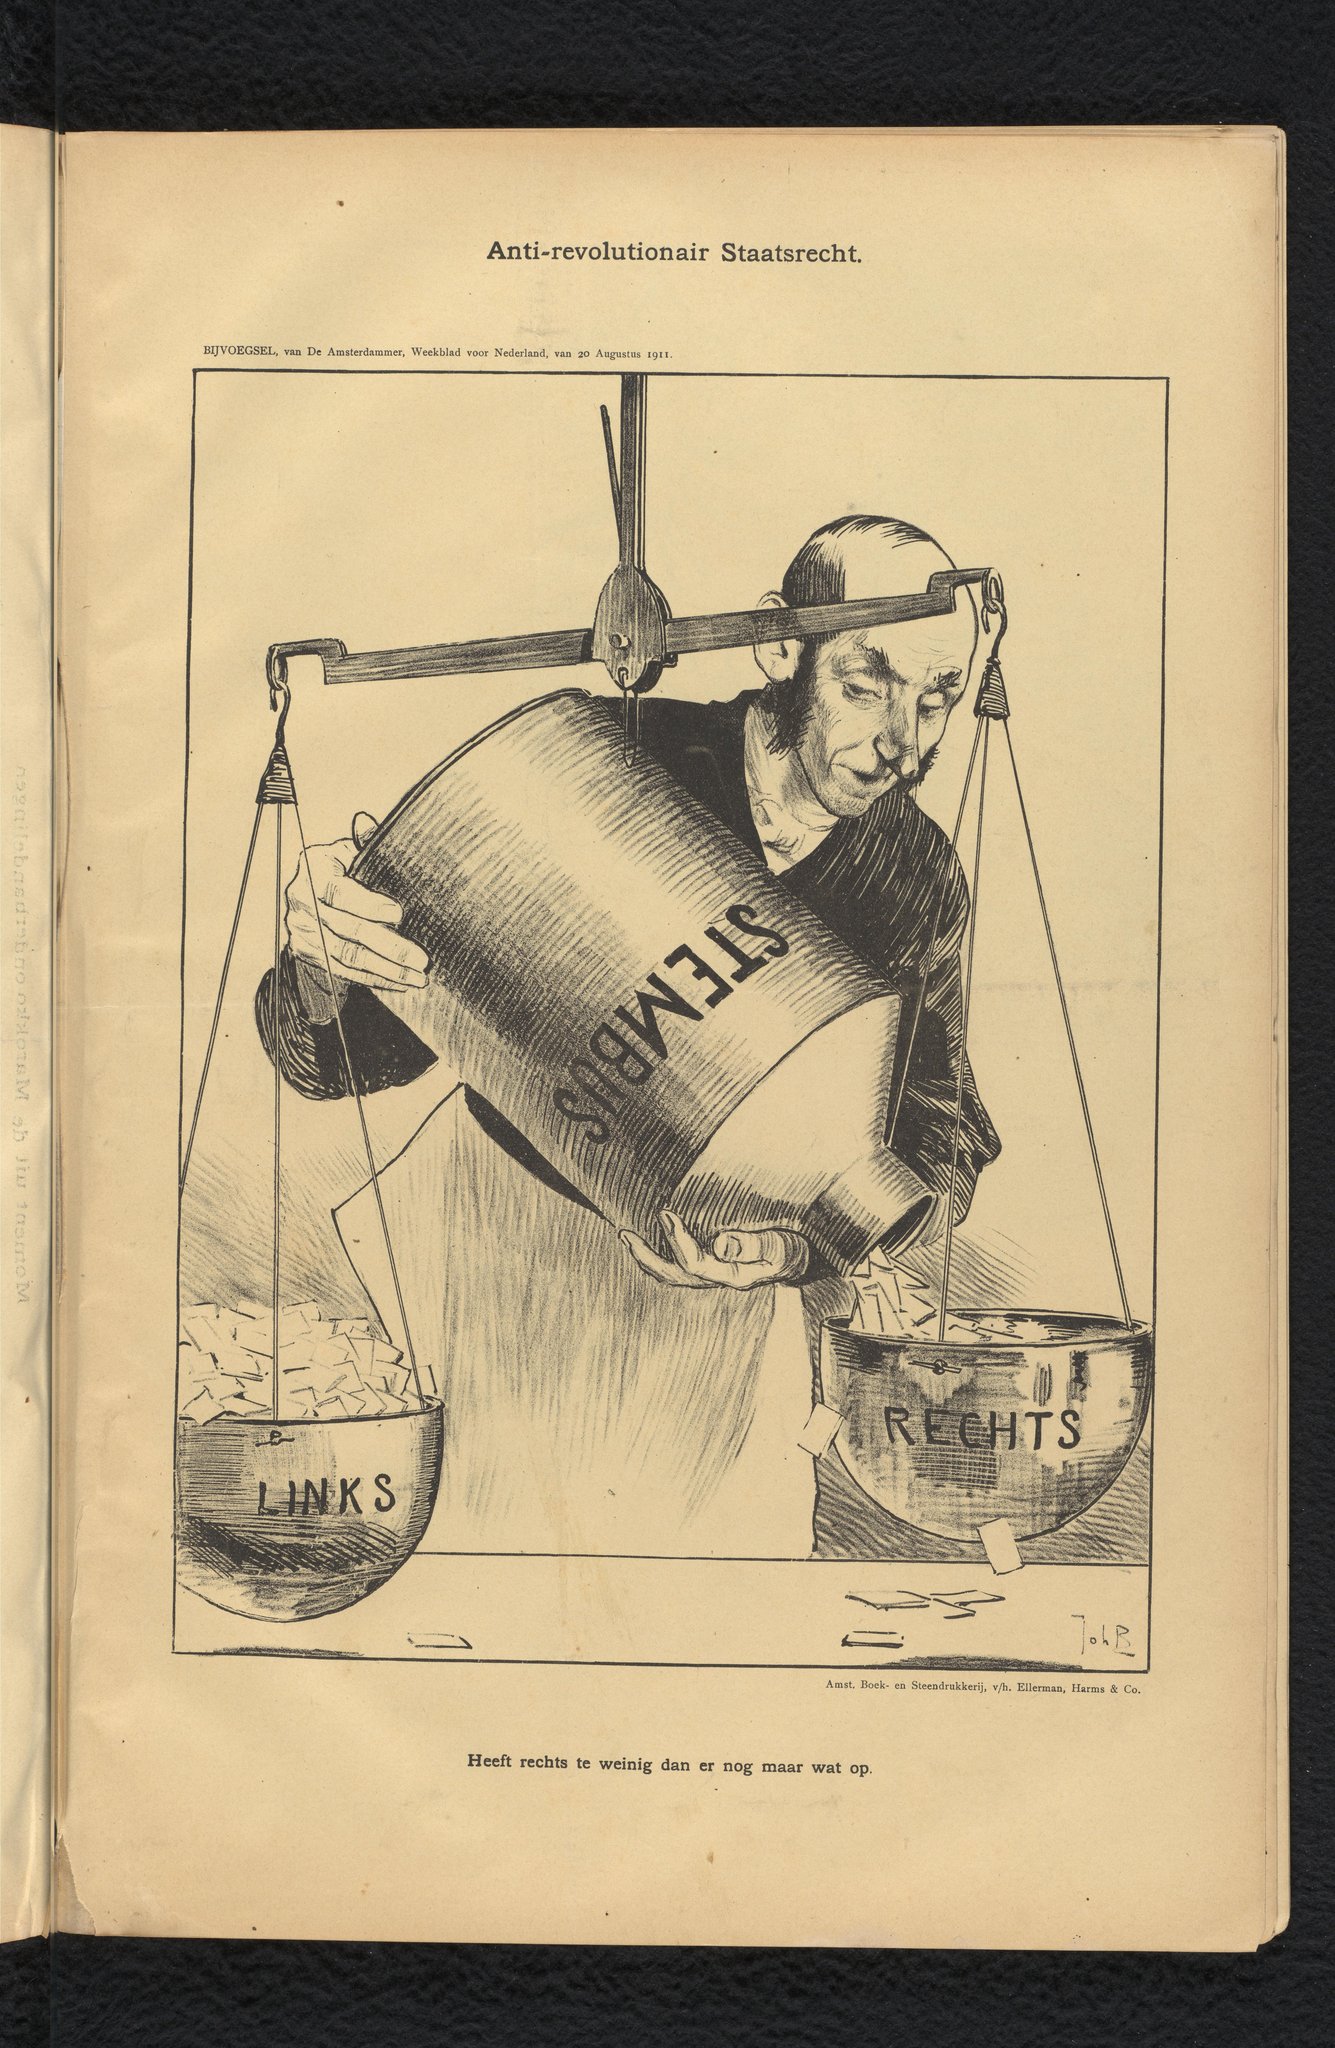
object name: cartoon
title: Anti-revolutionair Staatsrecht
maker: johan braakensiek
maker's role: draughtsman, print maker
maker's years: 1858-1940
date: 1911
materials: paper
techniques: lithograph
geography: netherlands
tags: voting receptacle, scales, shopkeeper, political caricatures and satires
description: Een kruidenier verdeelt de stemmen uit de stembus over de weegschalen van links en rechts.